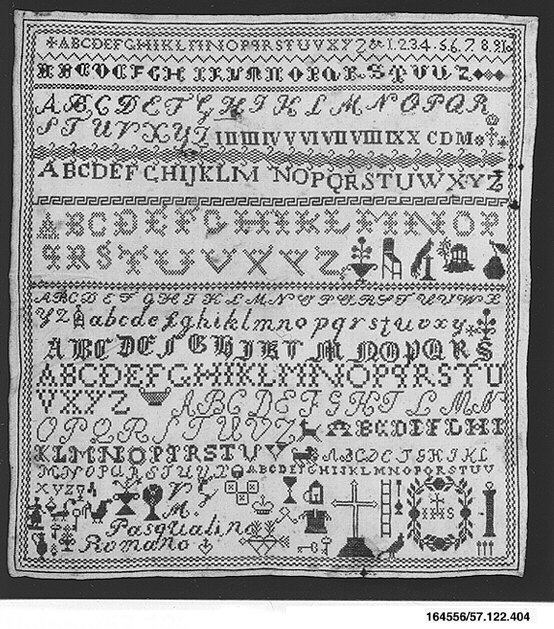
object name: sampler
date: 1801-1900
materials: cotton